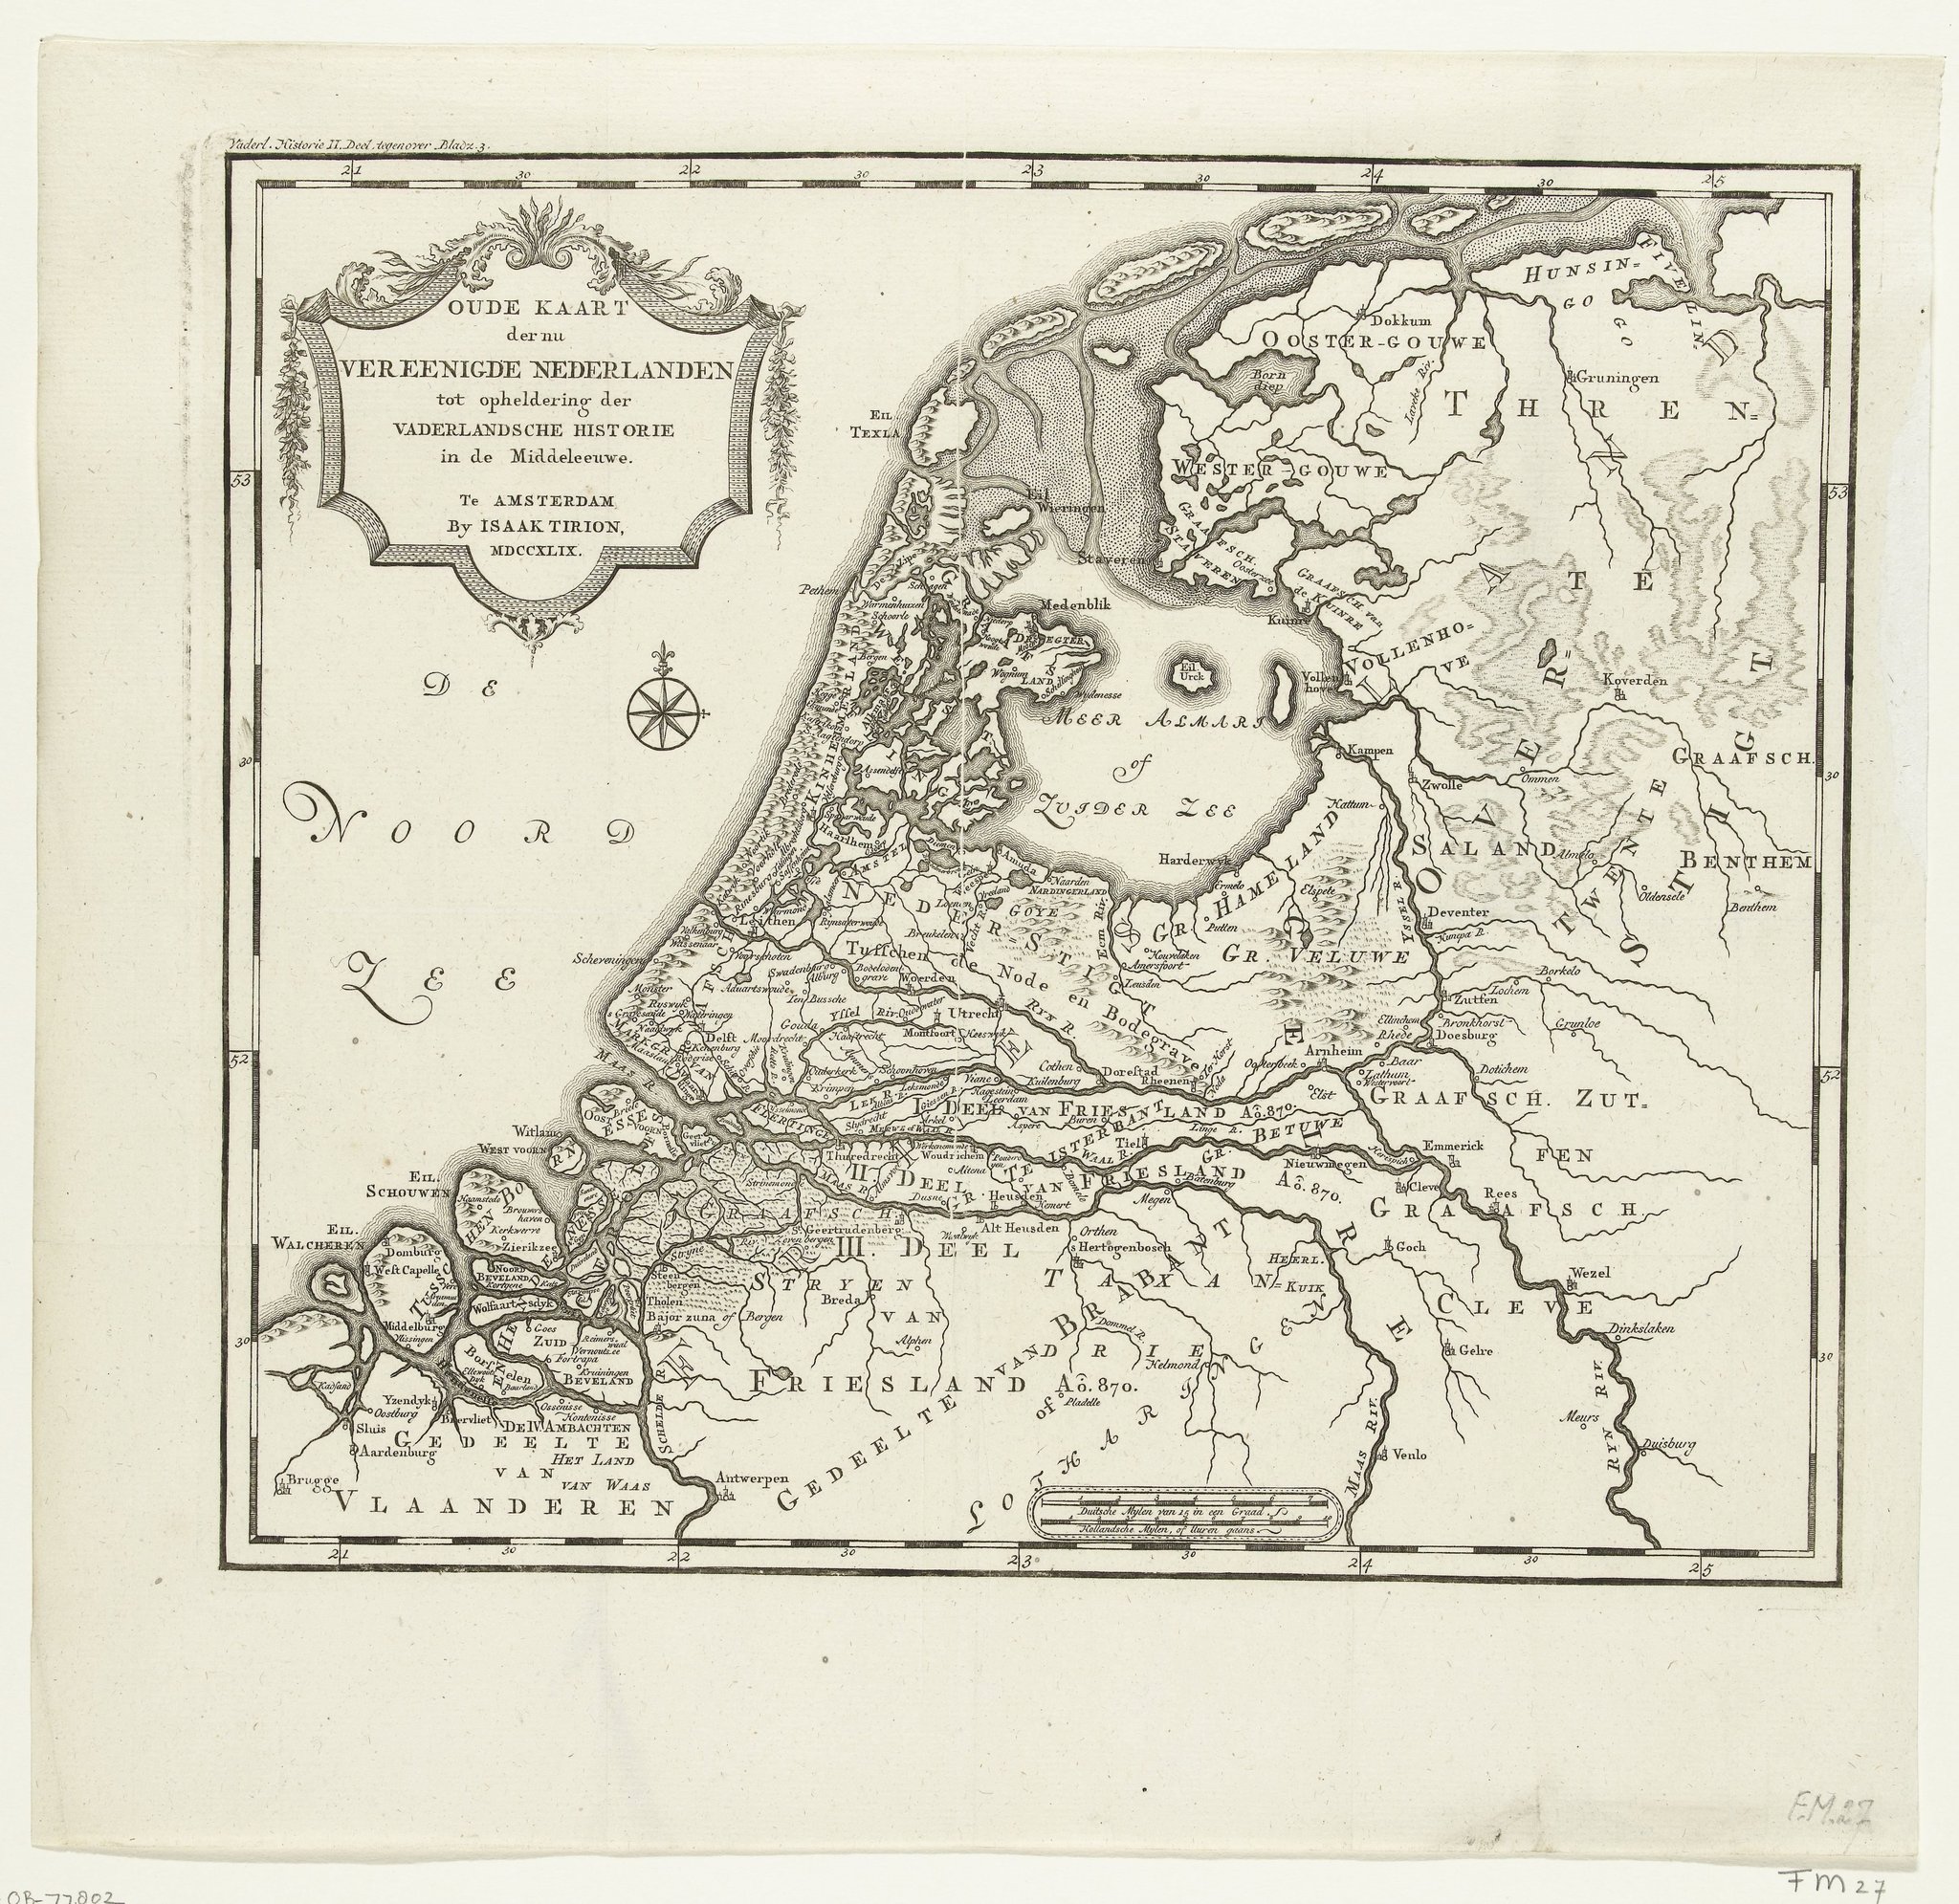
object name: history print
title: Historische kaart van Nederland tijdens de Middeleeuwen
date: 1749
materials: paper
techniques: etching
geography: amsterdam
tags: maps of separate countries or regions, netherlands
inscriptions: date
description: Illustratie voor: J. Wagenaar, Vaderlandsche historie, dl. II, 1749.